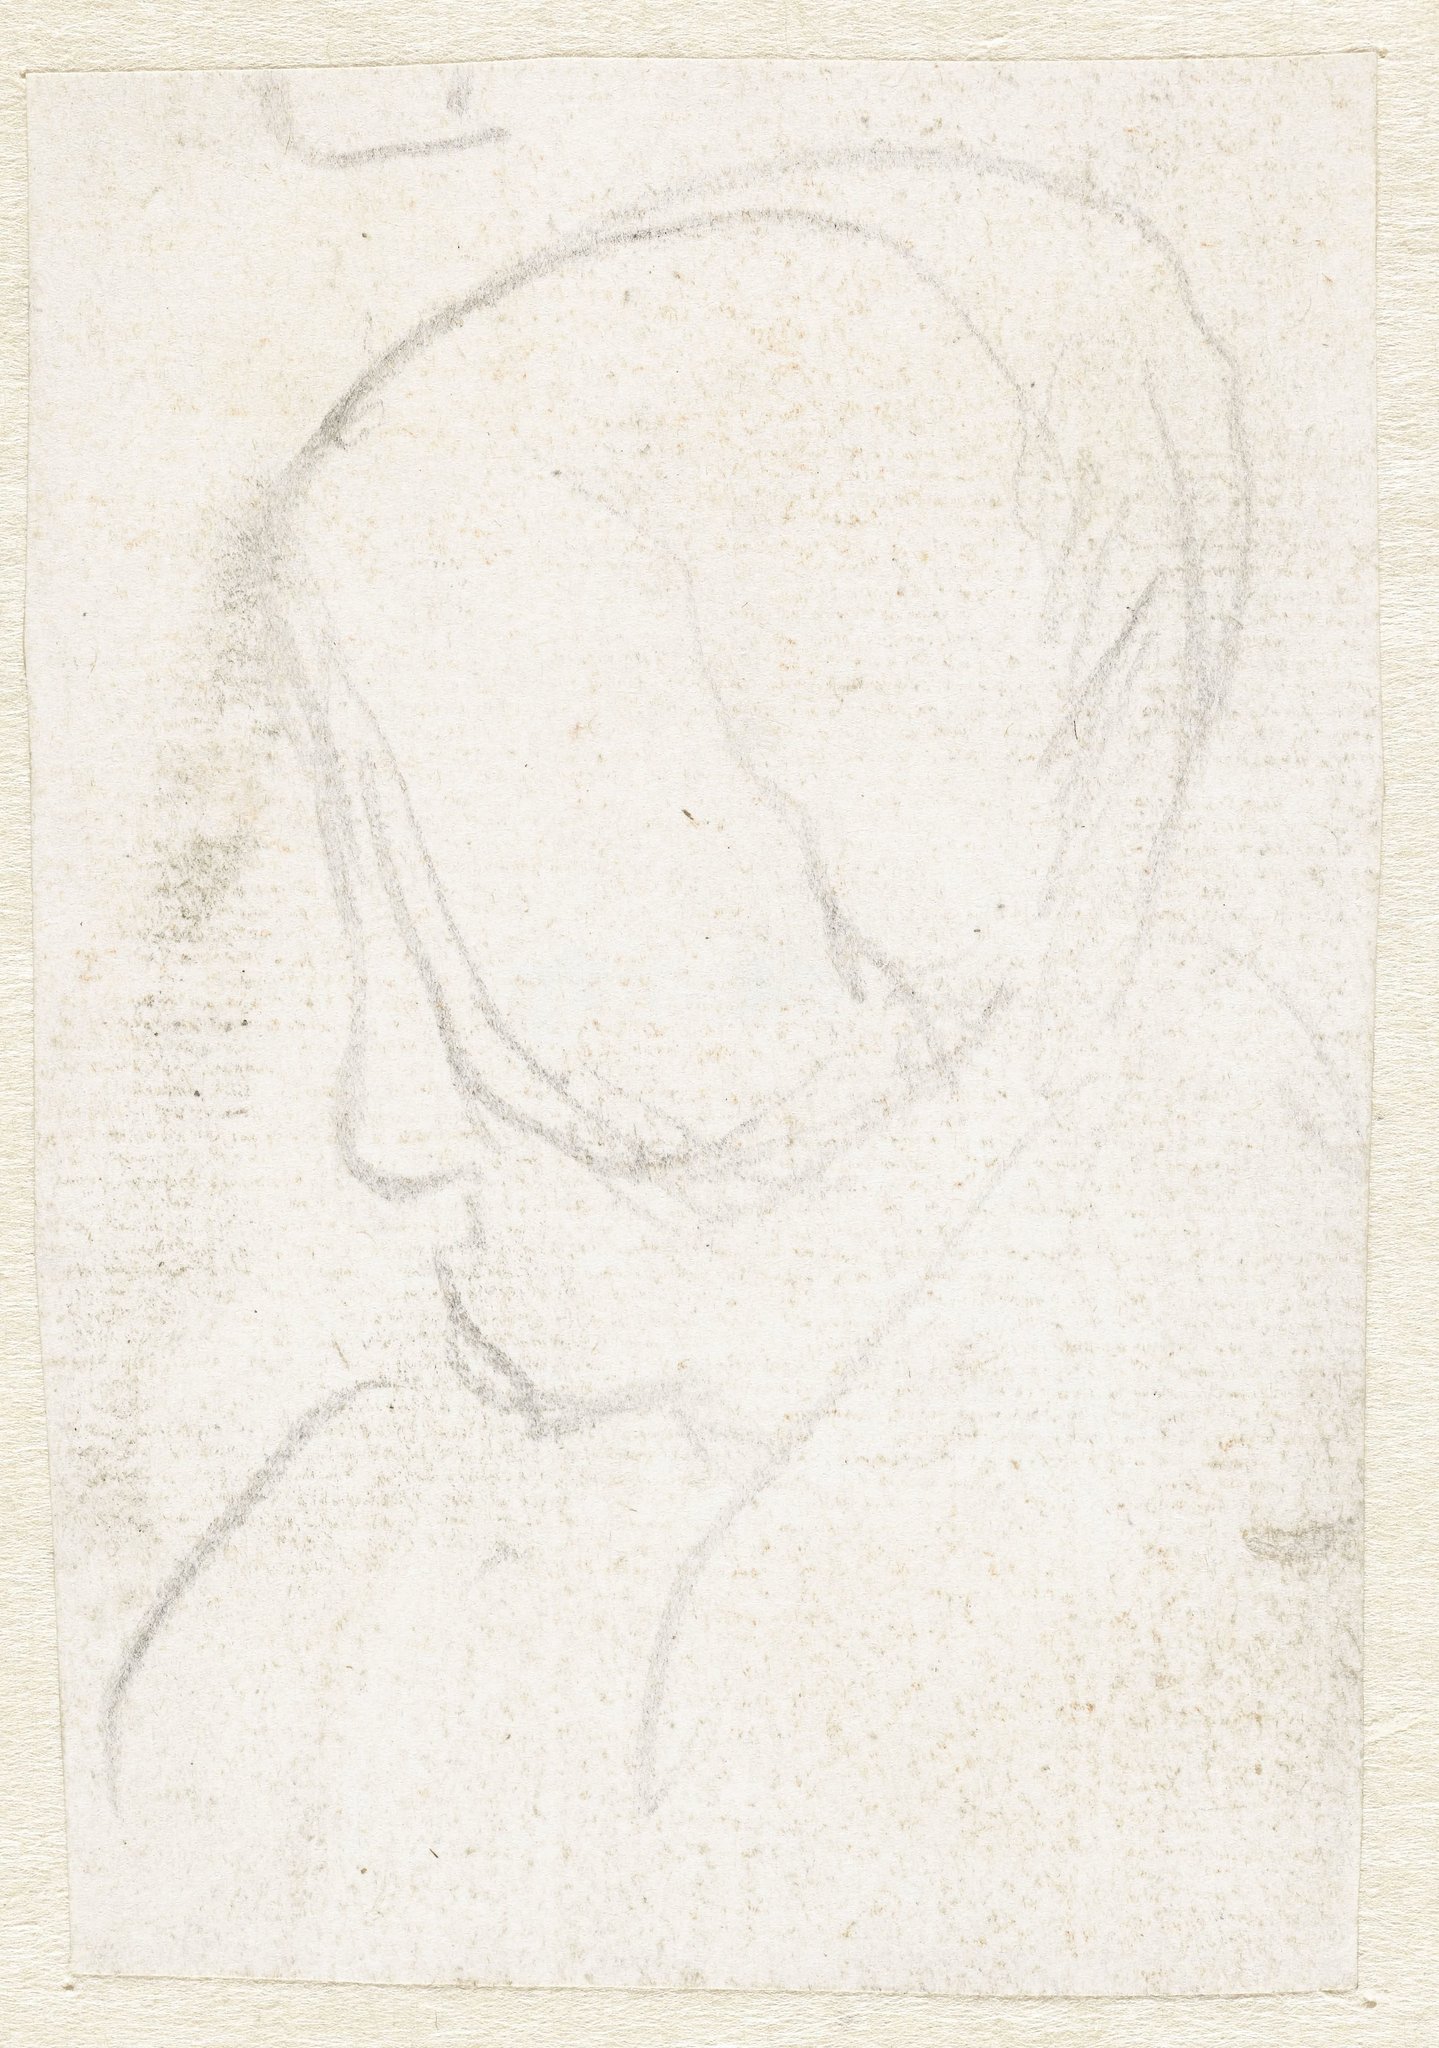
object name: drawing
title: Vrouwenkop met muts, in profiel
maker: simon andreas krausz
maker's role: draughtsman, print maker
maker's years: 1760-1825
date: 1770-1825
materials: paper, pencil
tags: head-gear: cap (+ women's clothes)